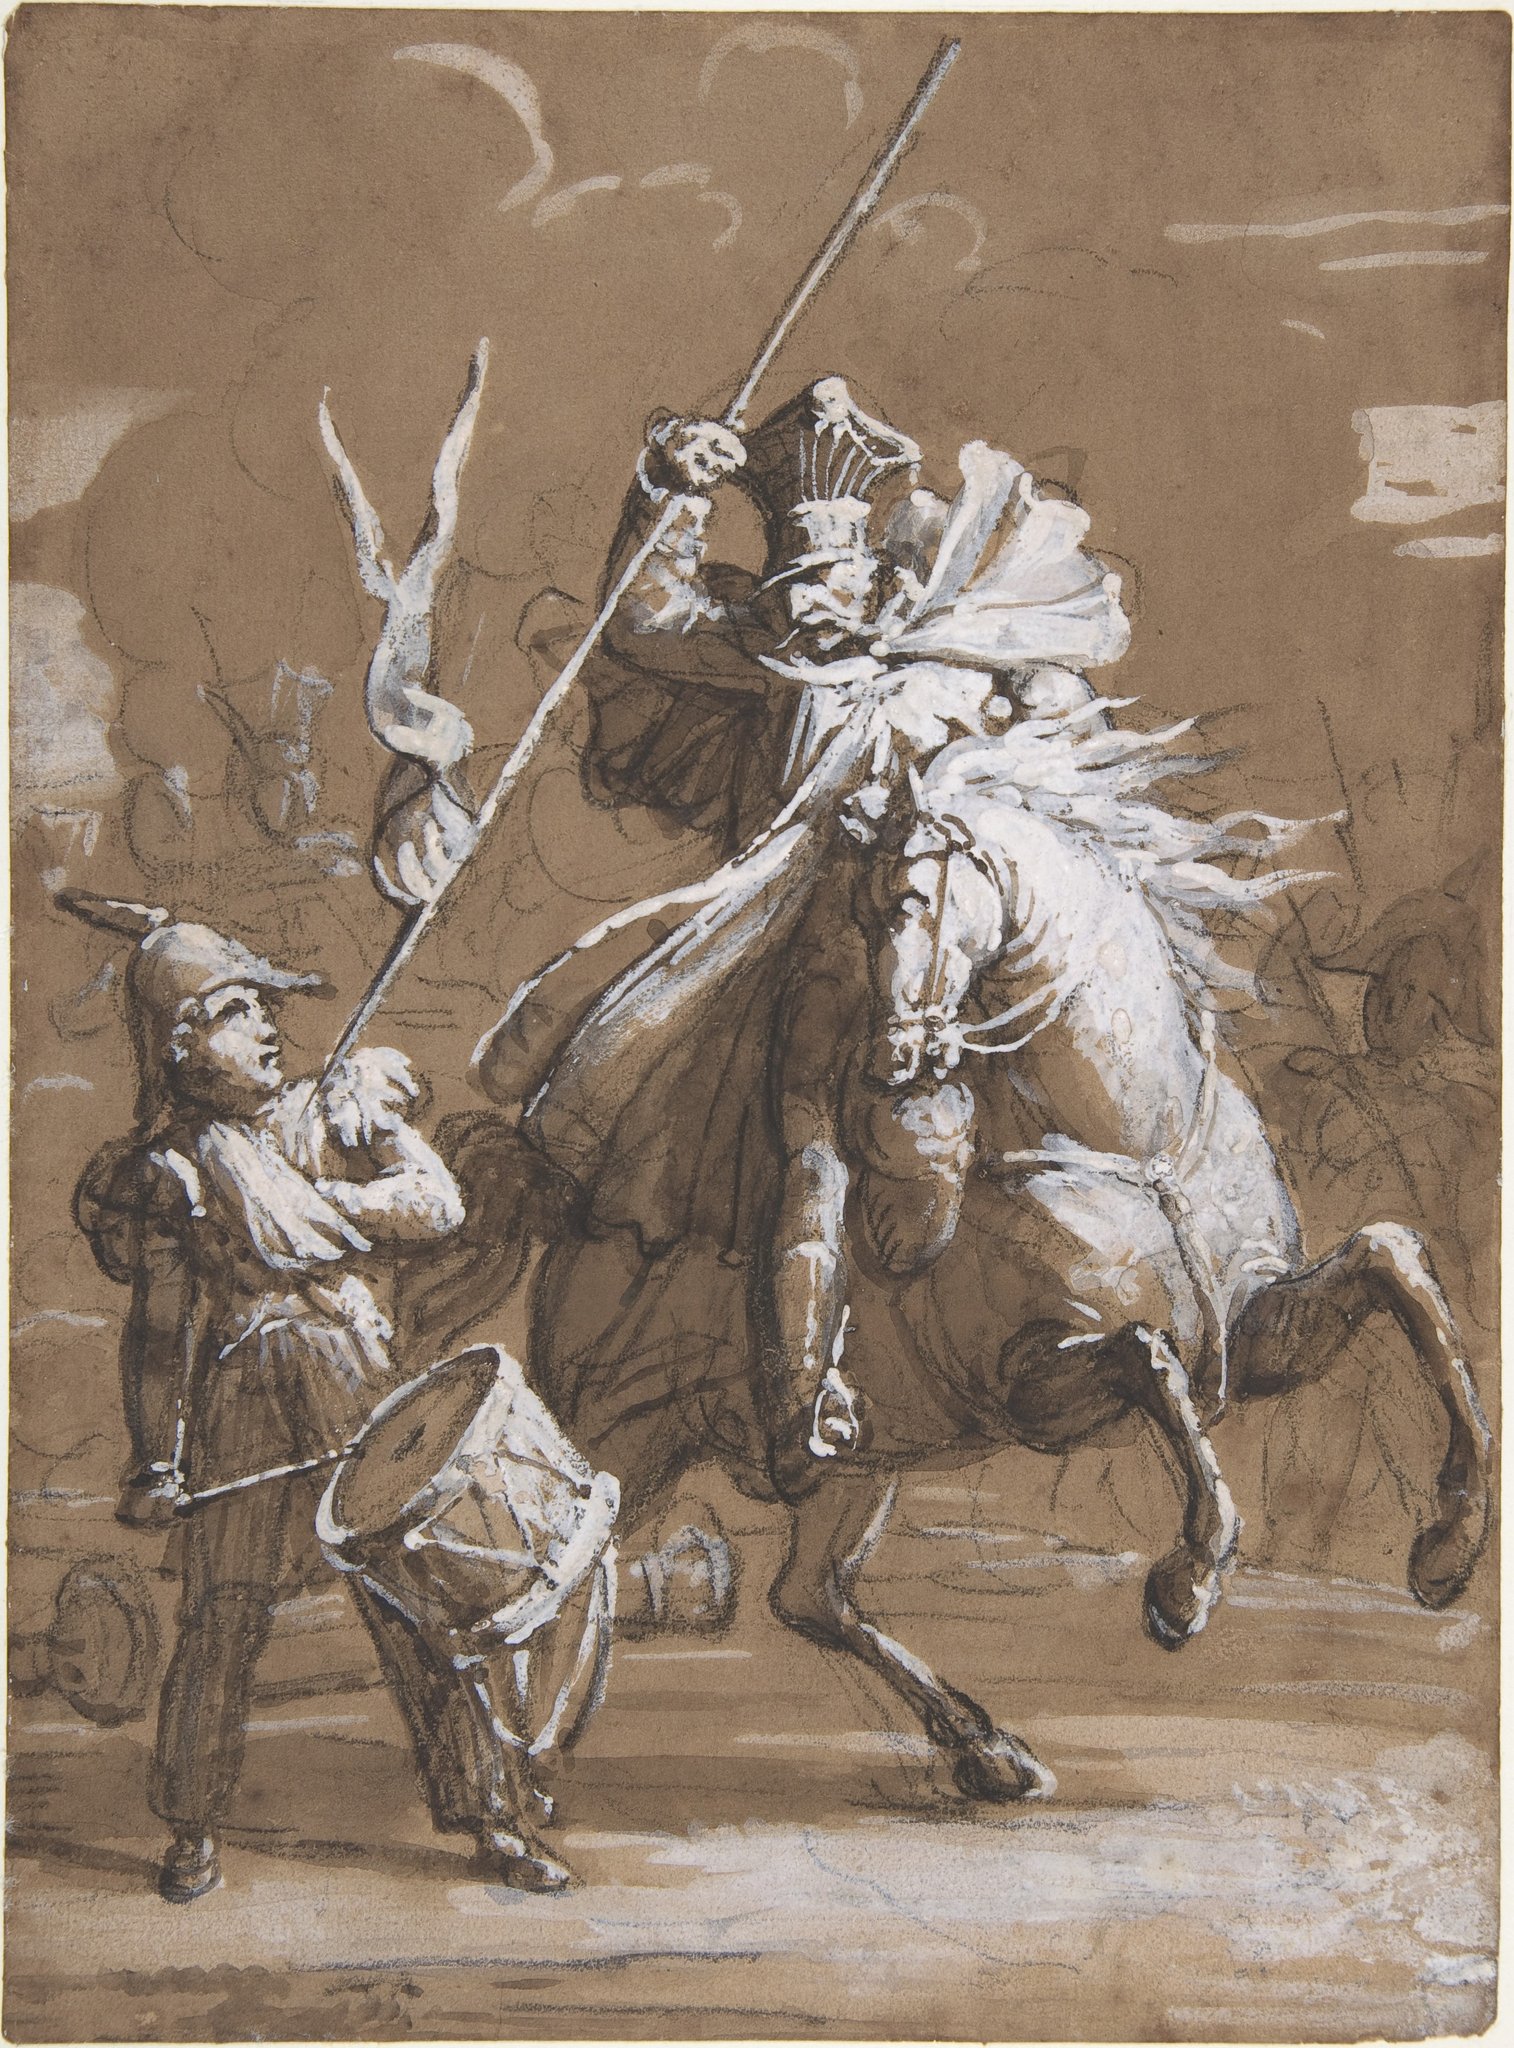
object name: drawing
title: Drummer Boy Attacked by a Cossack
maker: jean victor schnetz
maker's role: artist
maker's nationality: french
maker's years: 1787-1870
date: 1817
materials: chalk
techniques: brush, heightening, wash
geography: france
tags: men,drums,horses,musicians